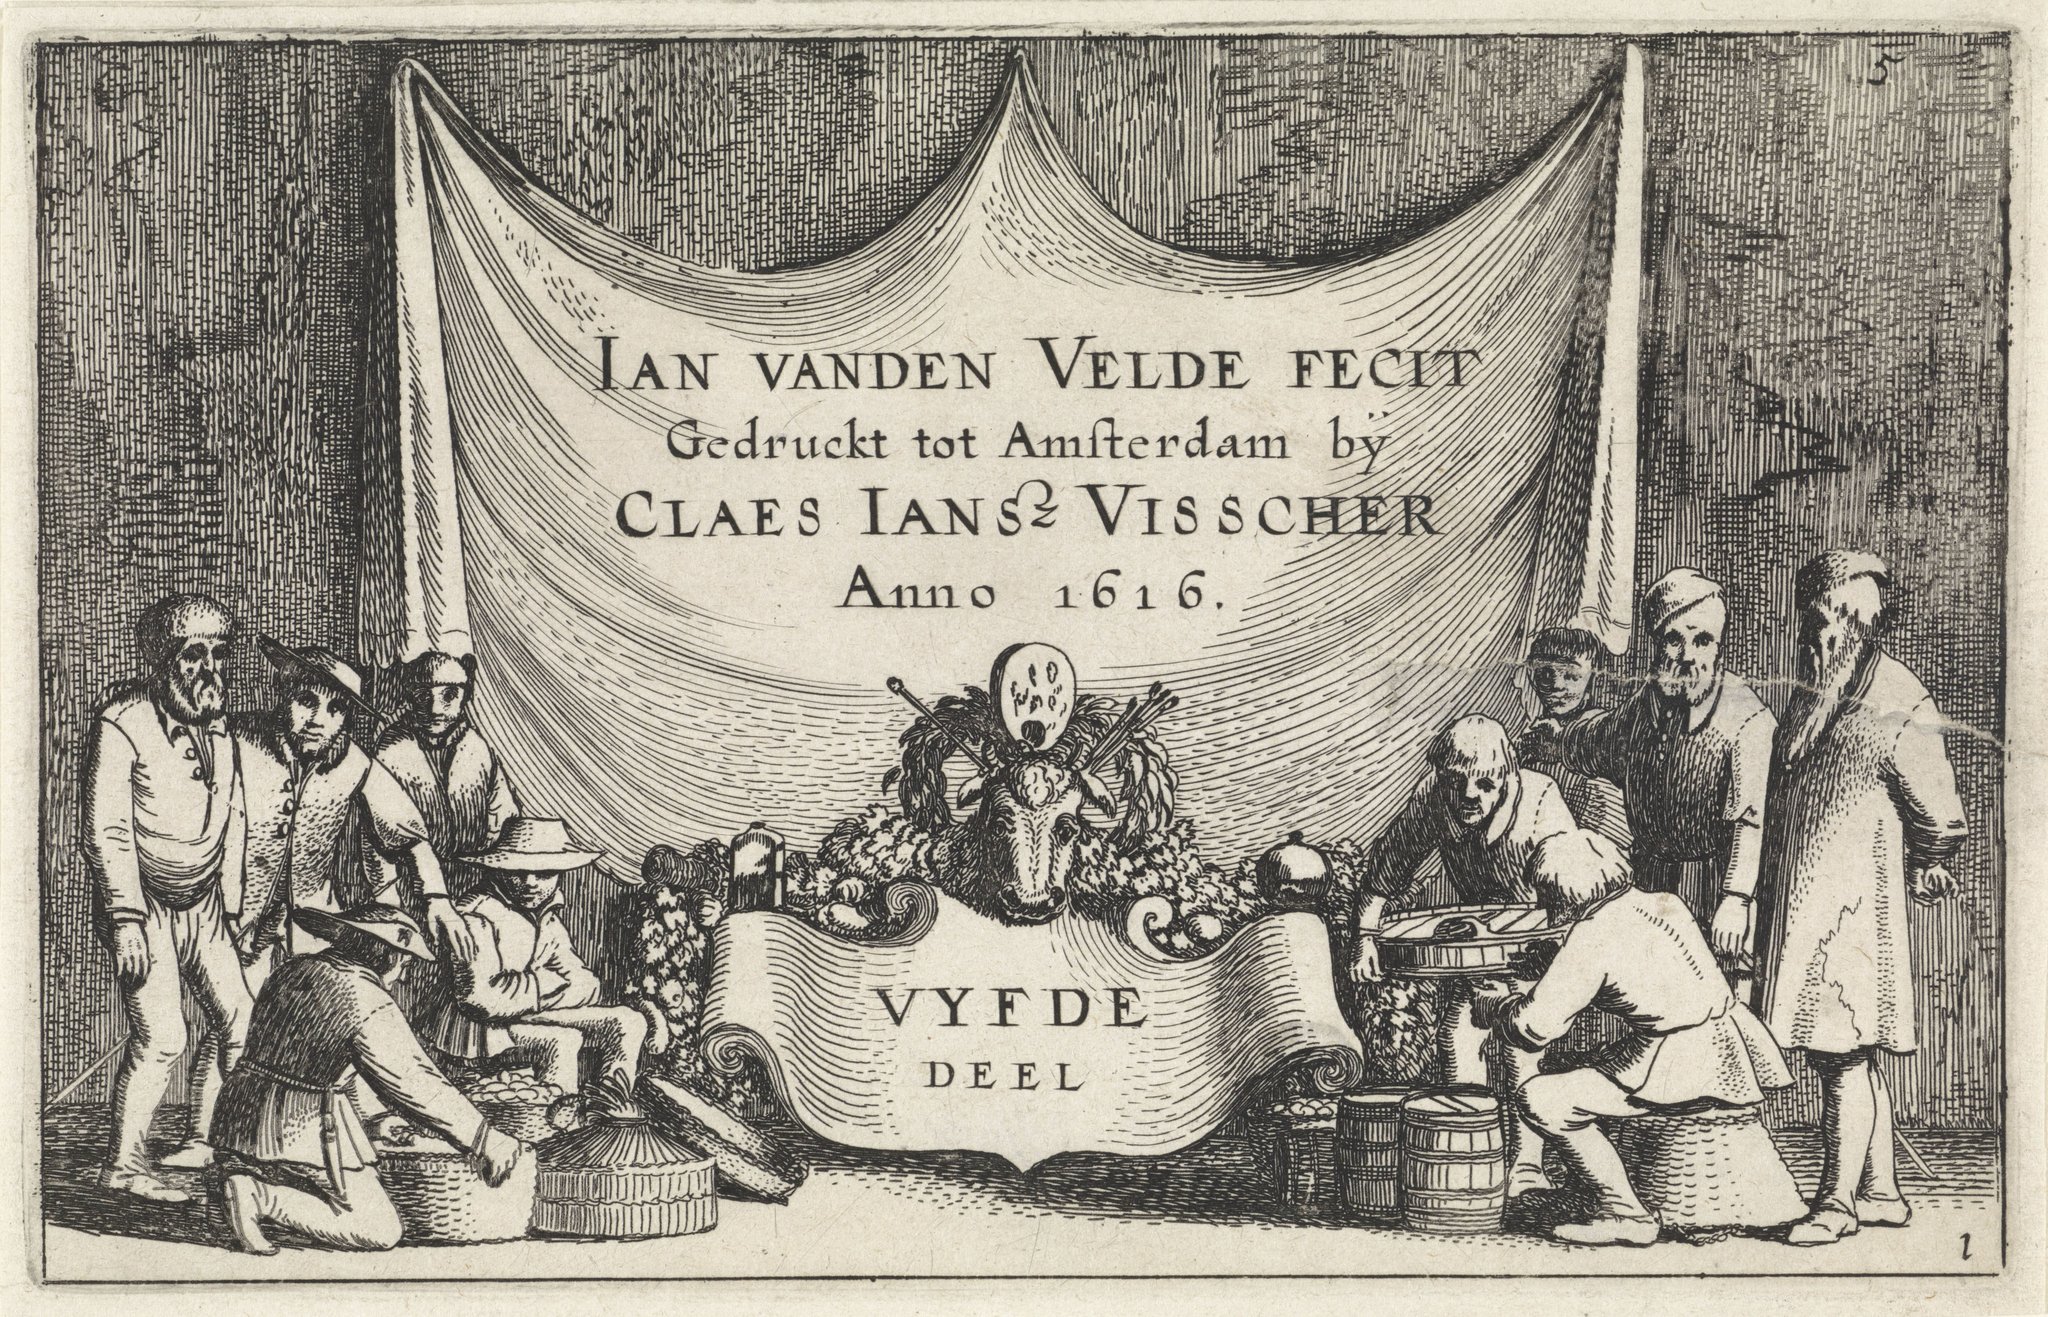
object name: print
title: Landschappen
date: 1616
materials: paper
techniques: etching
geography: northern netherlands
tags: wooden container: barrel, cask, bucket, farmers, container made of plant material other than wood: basket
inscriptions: collector's mark: Lugt 964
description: Zittende en staande figuren bij tonnen en manden, aan weerszijden van een doek met daarop de titel. In het midden een stierenkop met schildersattributen. Titelprent van deel vijf van een serie van in totaal zestig prenten met landschappen, verdeeld over vijf delen van elk twaalf prenten.